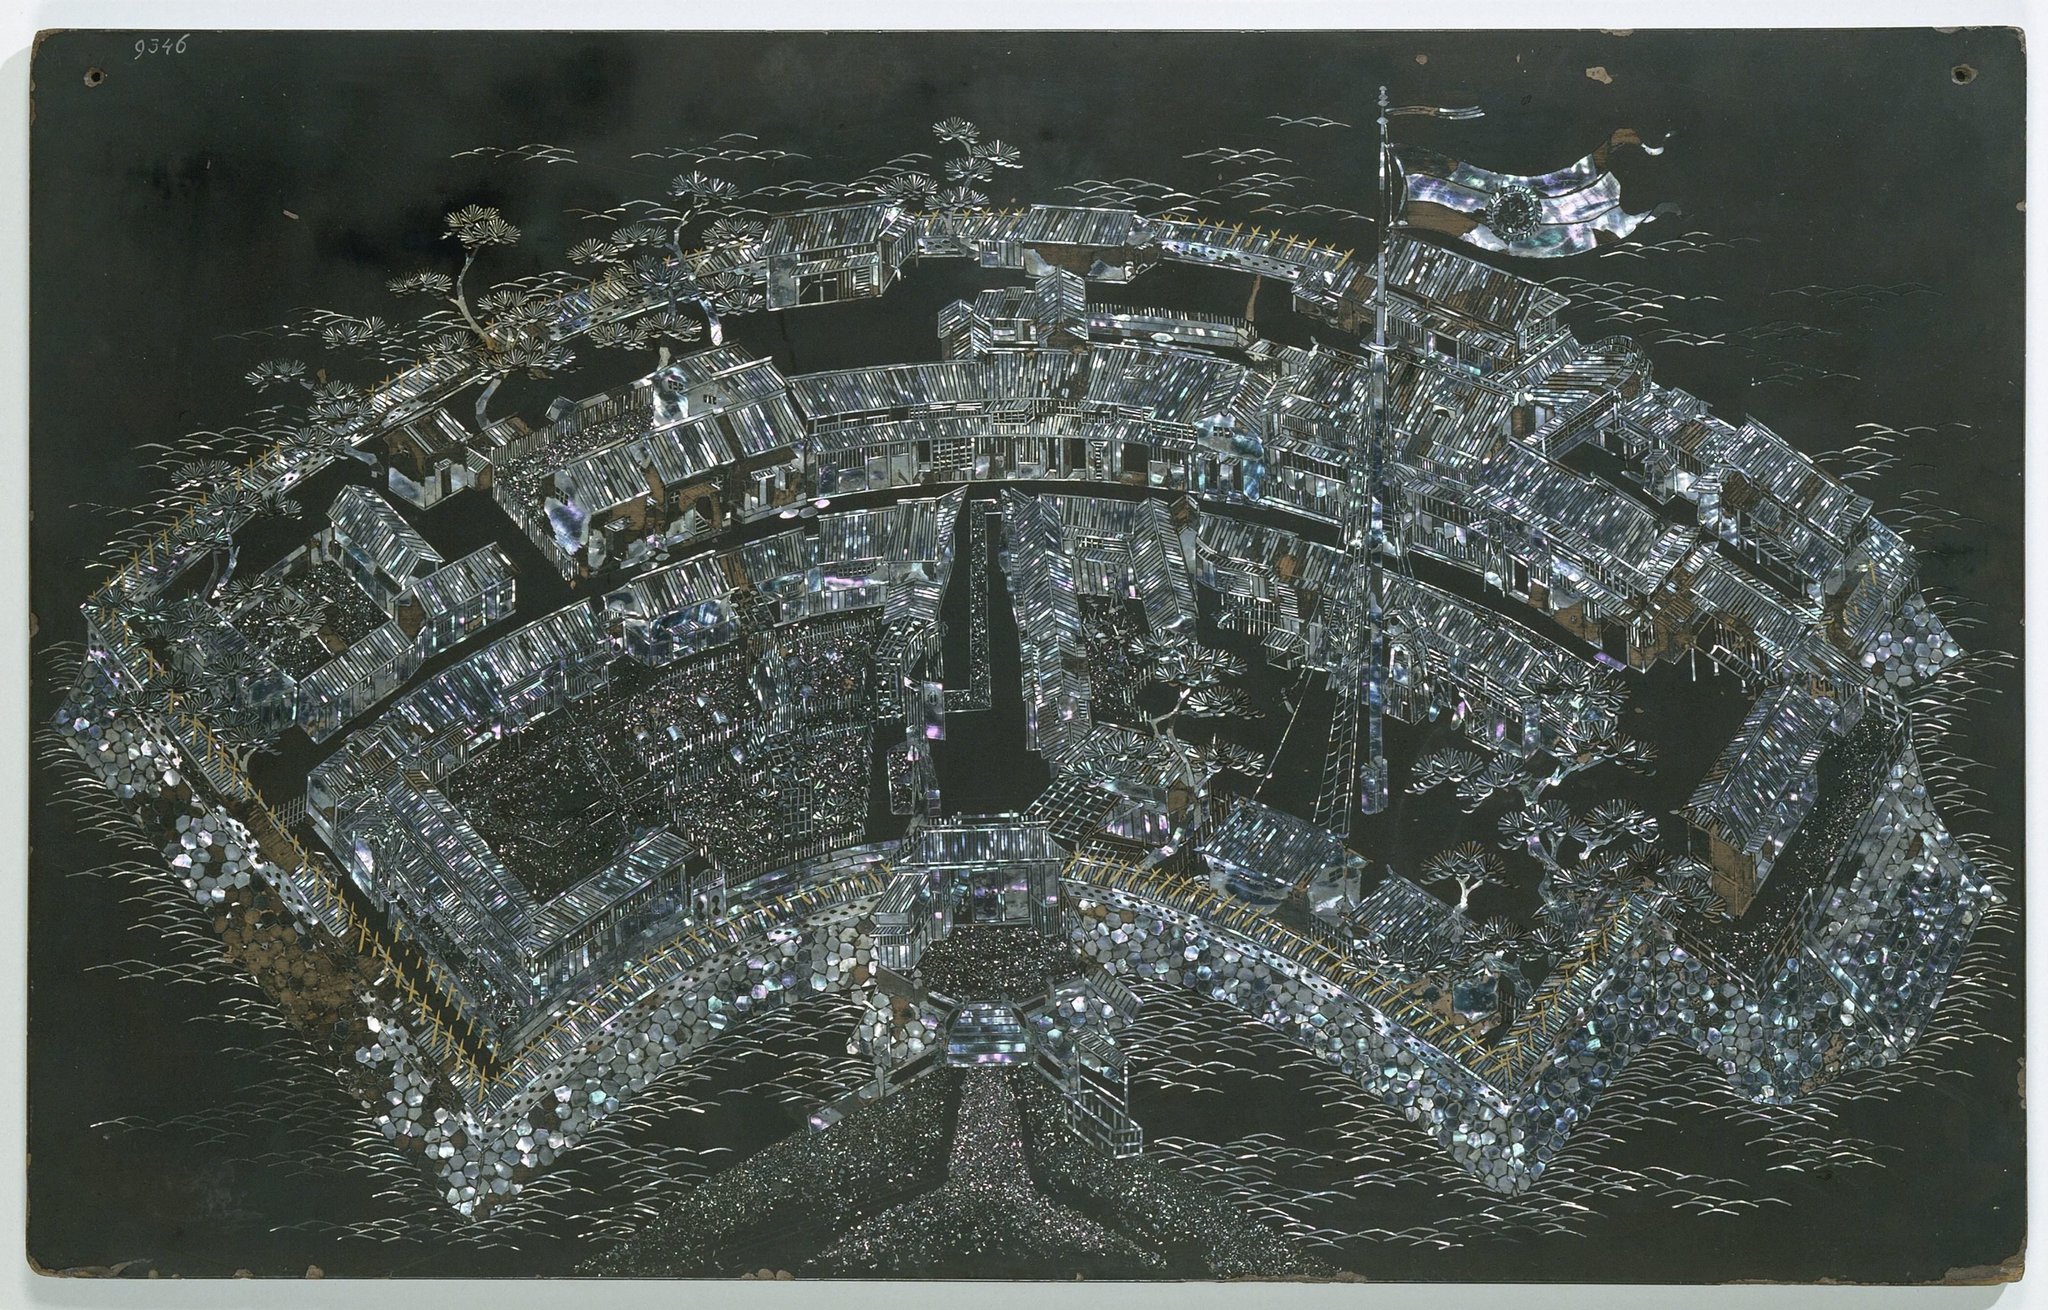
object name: lacquer panel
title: Lacquer panel depicting Deshima Island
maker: Anonymous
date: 1800-1820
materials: lacquer, mother of pearl, wood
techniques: inlay, lacquer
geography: japan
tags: maps of cities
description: Deshima, the Dutch East India Company (VOC) trading post in Japan, appears here on a lacquer panel. The scene is meticulously inlaid with thin strips of motherof-pearl. It shows the details of the buildings, even the VOC monogram on the flag. In the 19th century, lacquer with mother-of-pearl inlay was a popular Japanese product.